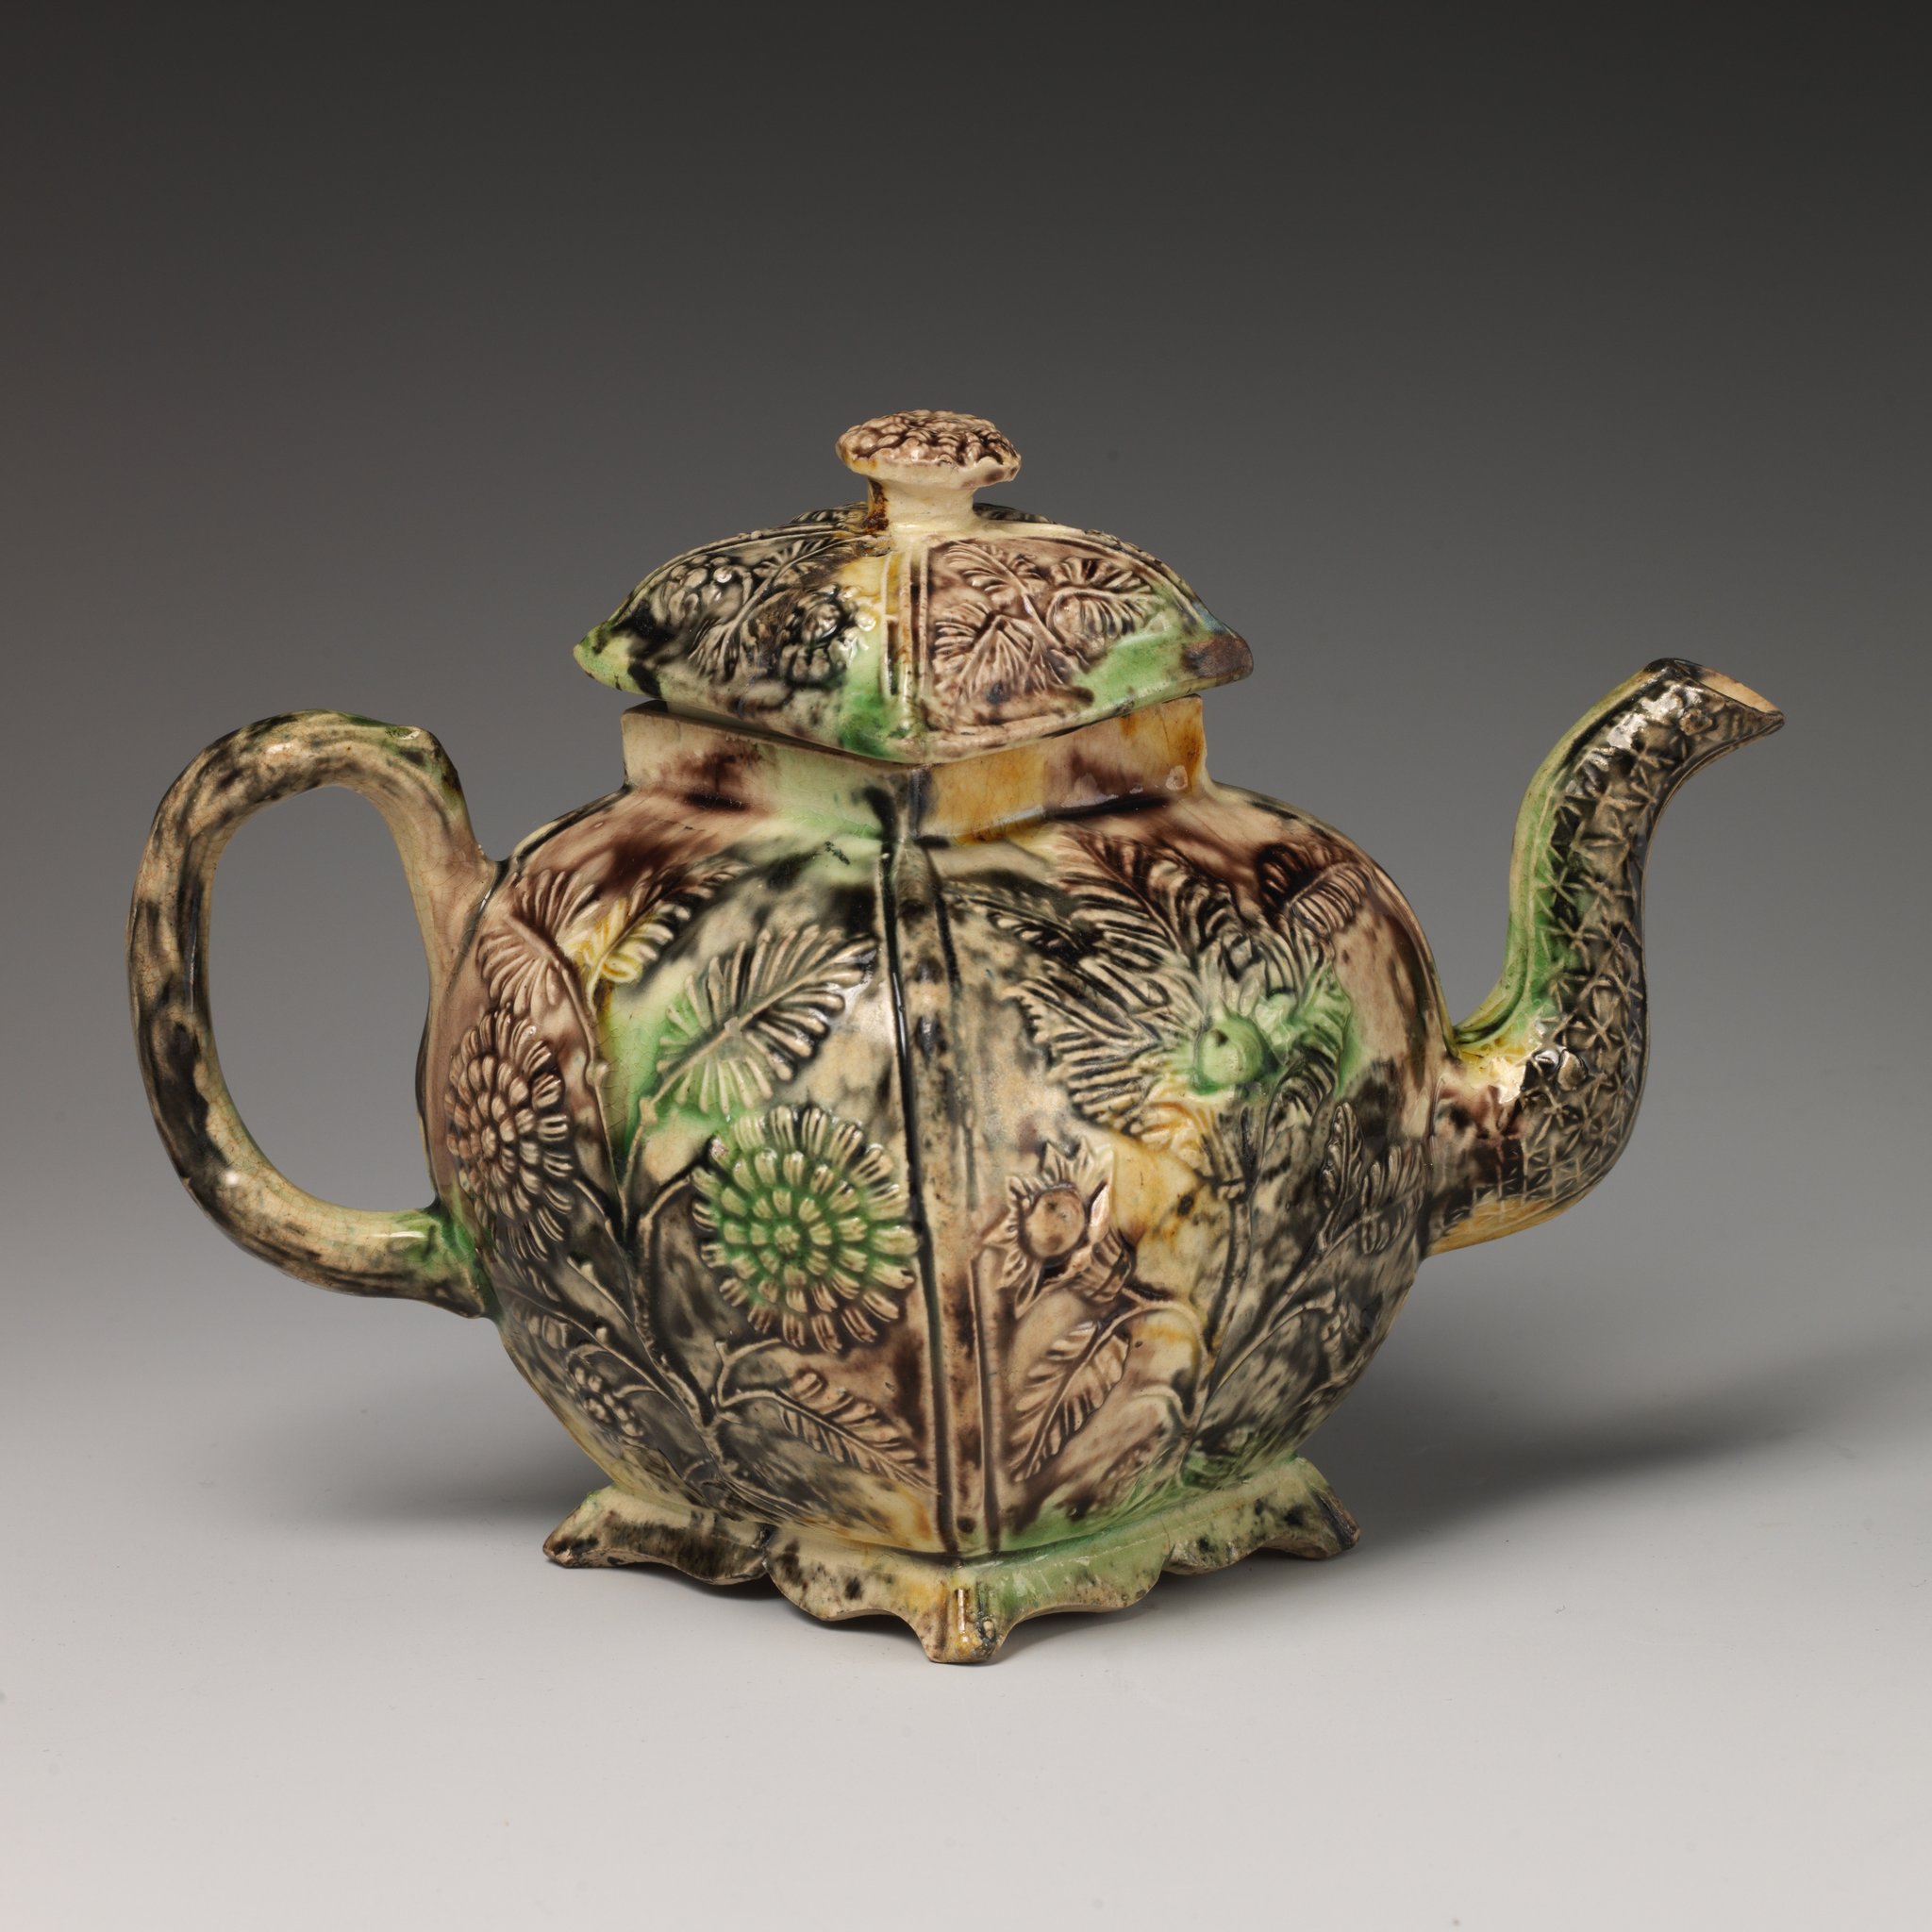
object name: teapot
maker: thomas whieldon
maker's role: maker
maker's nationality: british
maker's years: 1719-1795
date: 1755-1760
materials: shell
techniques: glazing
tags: flowers